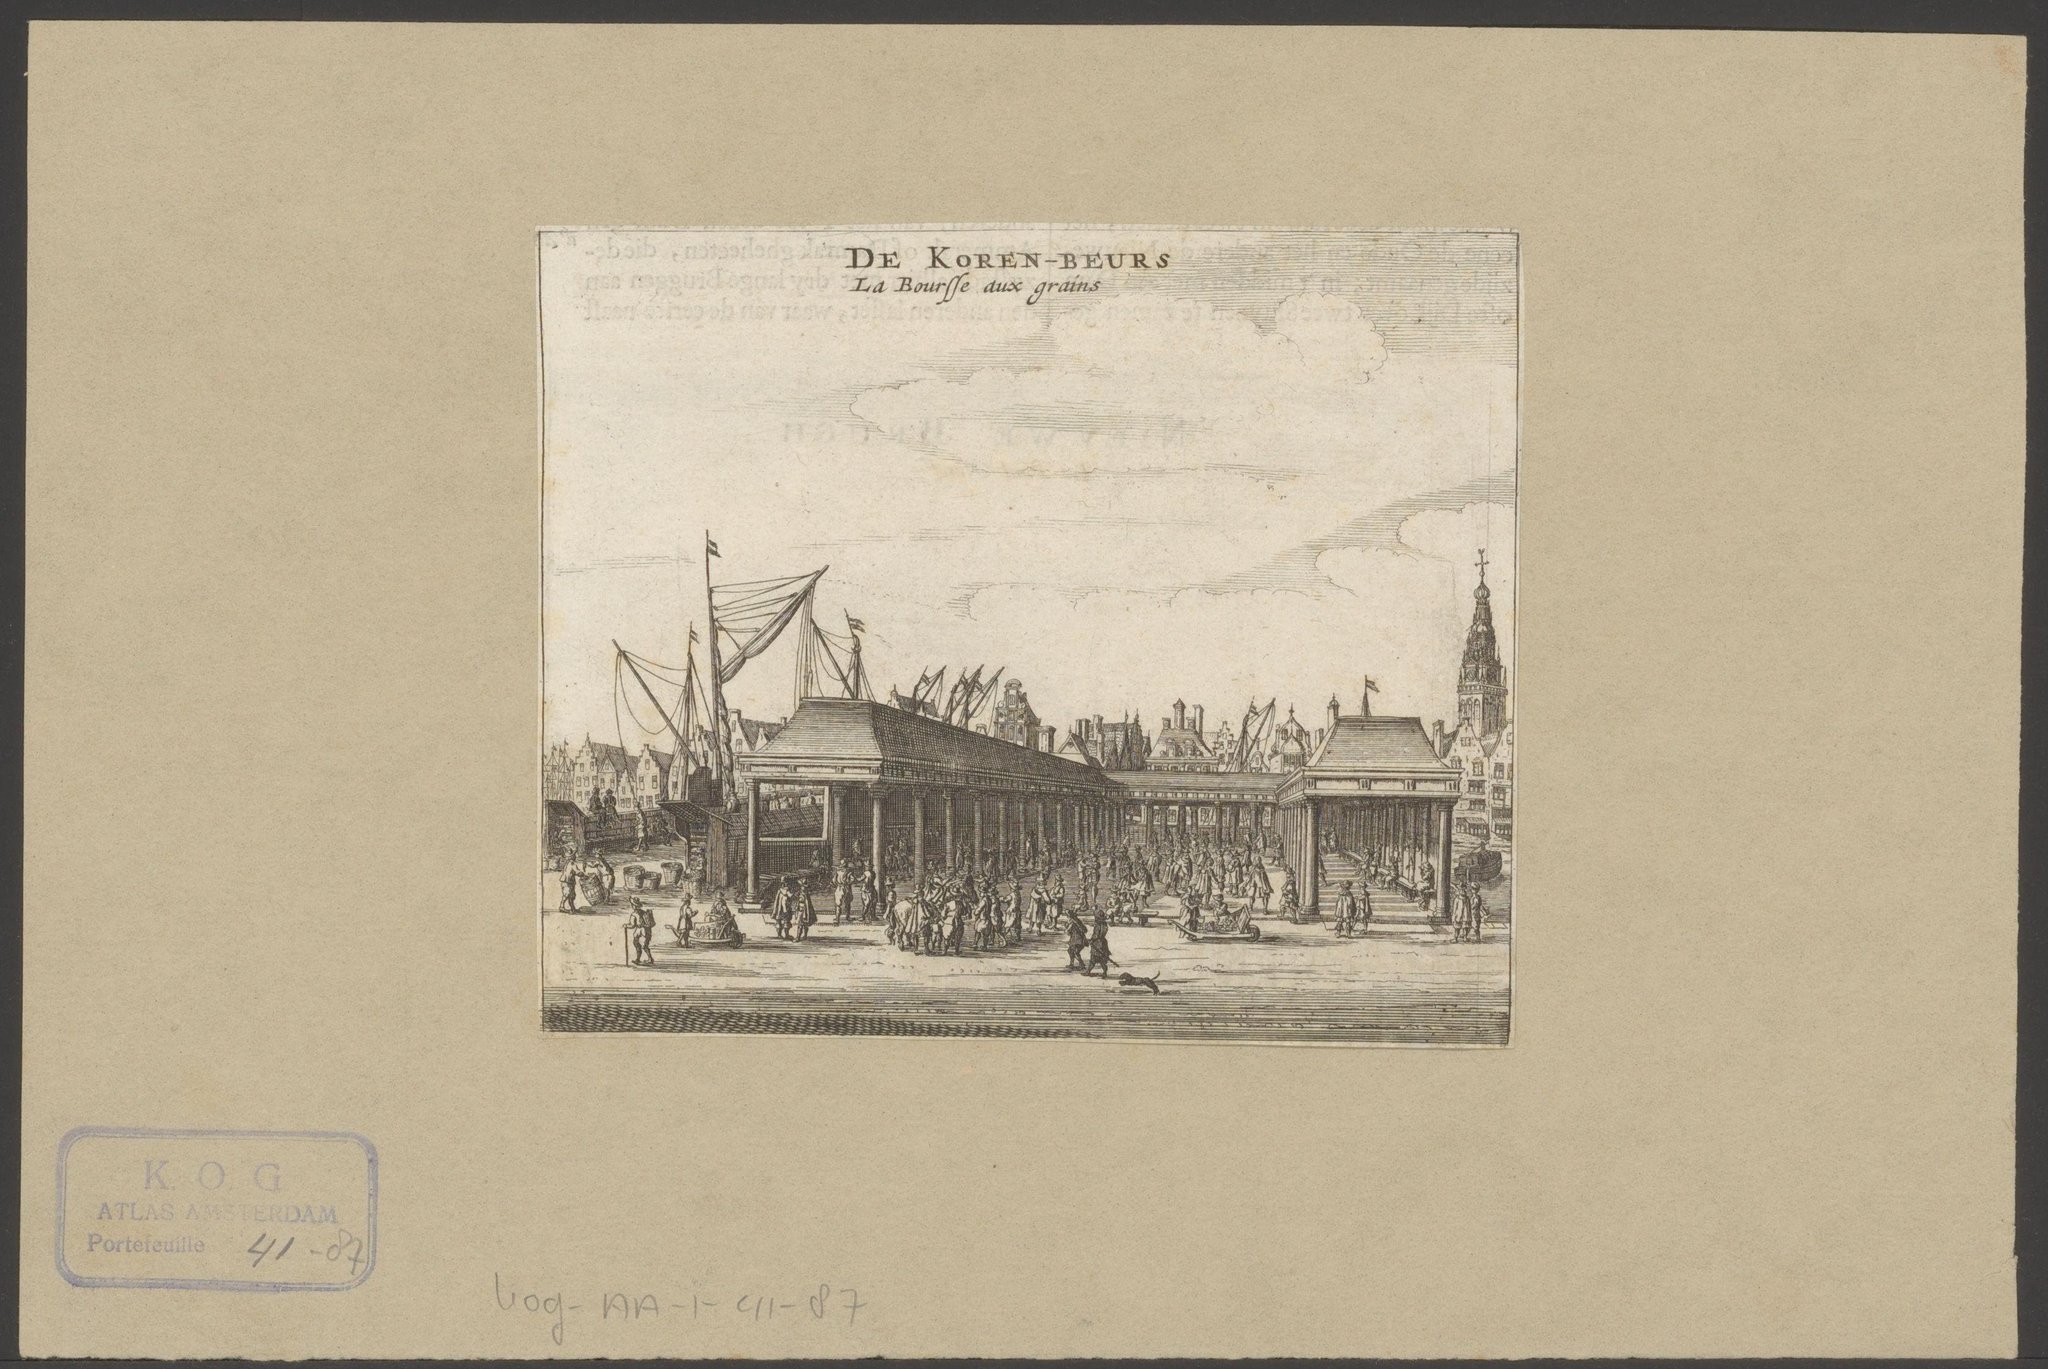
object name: book illustration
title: La Boursse aux grains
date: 1665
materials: paper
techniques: engraving, etching, letterpress printing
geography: amsterdam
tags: sailing-ship, sailing-boat, market-hall, parts of church exterior and annexes: tower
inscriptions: collector's mark: ‘41-87’ Lugt 1641b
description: Huidige staat van prent (met Franse titel) uit: Domselaer, Tobias en Isaac Commelin. Beschryvinge van Amsterdam: haar eerste oorspronk uyt den huyze der heeren van Aemstel en Aemstellant (…). 6 dln. Amsterdam: Marcus Willemsz van Doornick, 1665, dl. 3, p. 173.